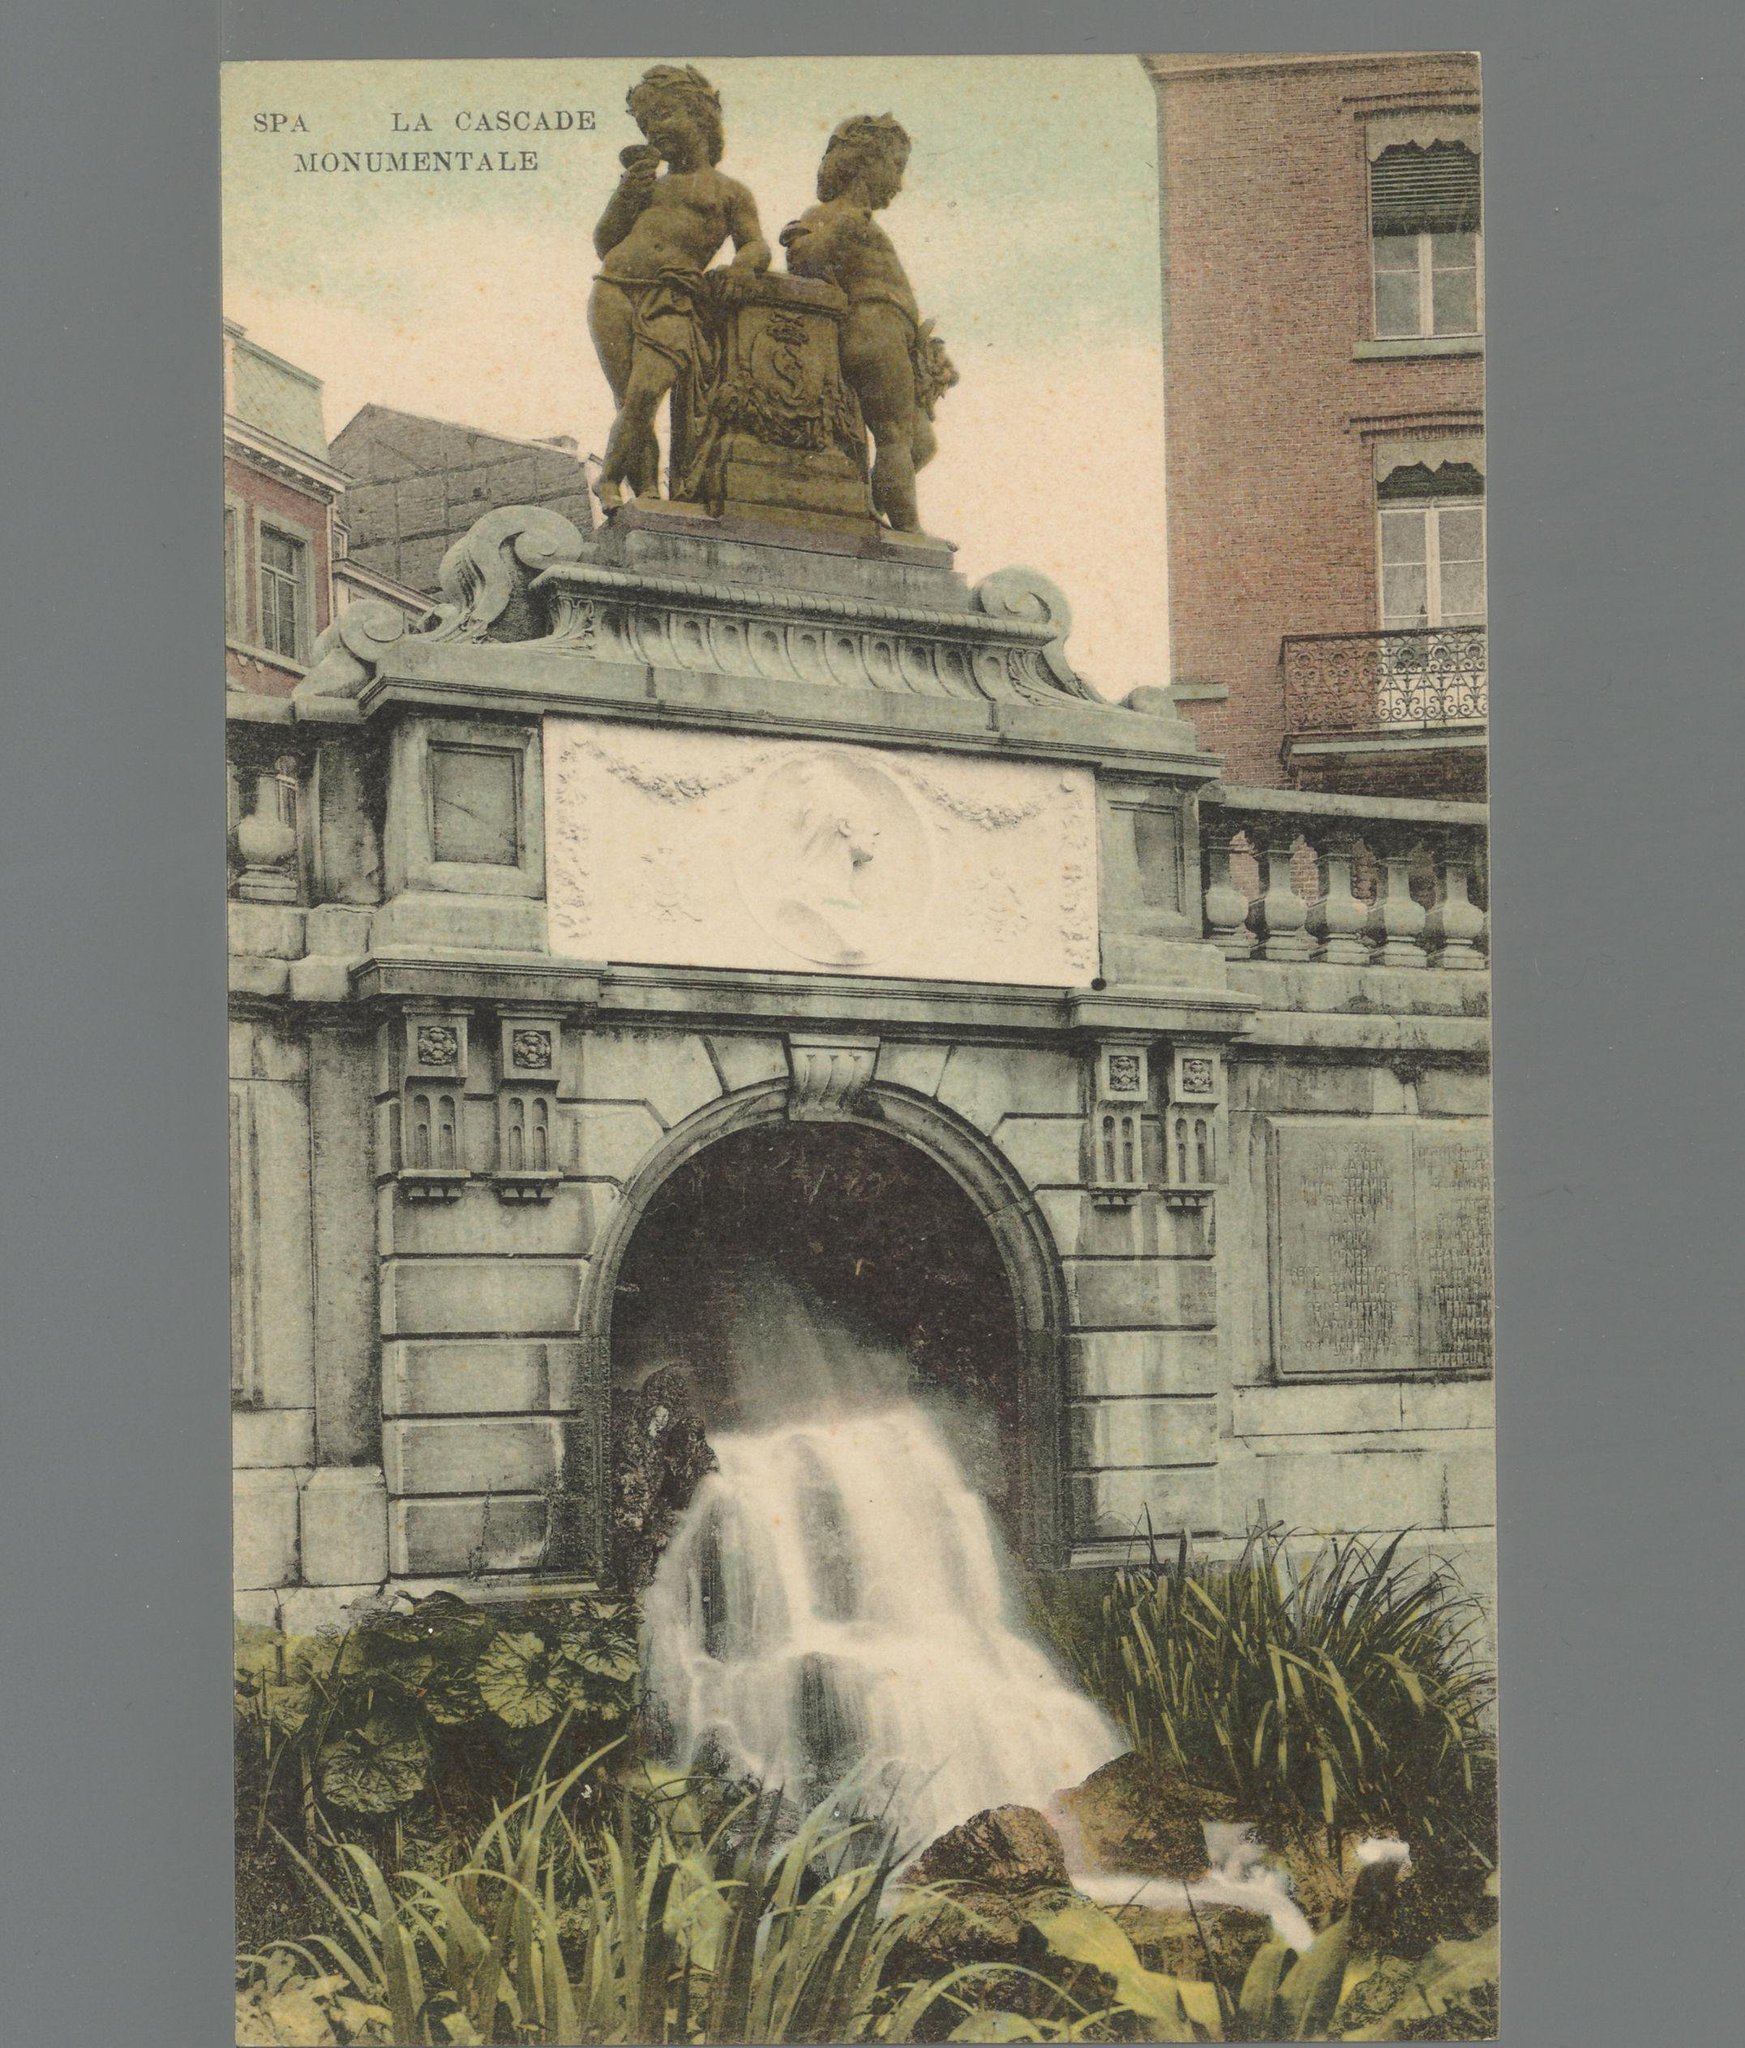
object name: ansichtkaart, prentbriefkaart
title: Spa. La cascade monumentale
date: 1906-1930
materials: cardboard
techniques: photograph, lithograph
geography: spa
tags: monumental adornments (in city), garden cascade